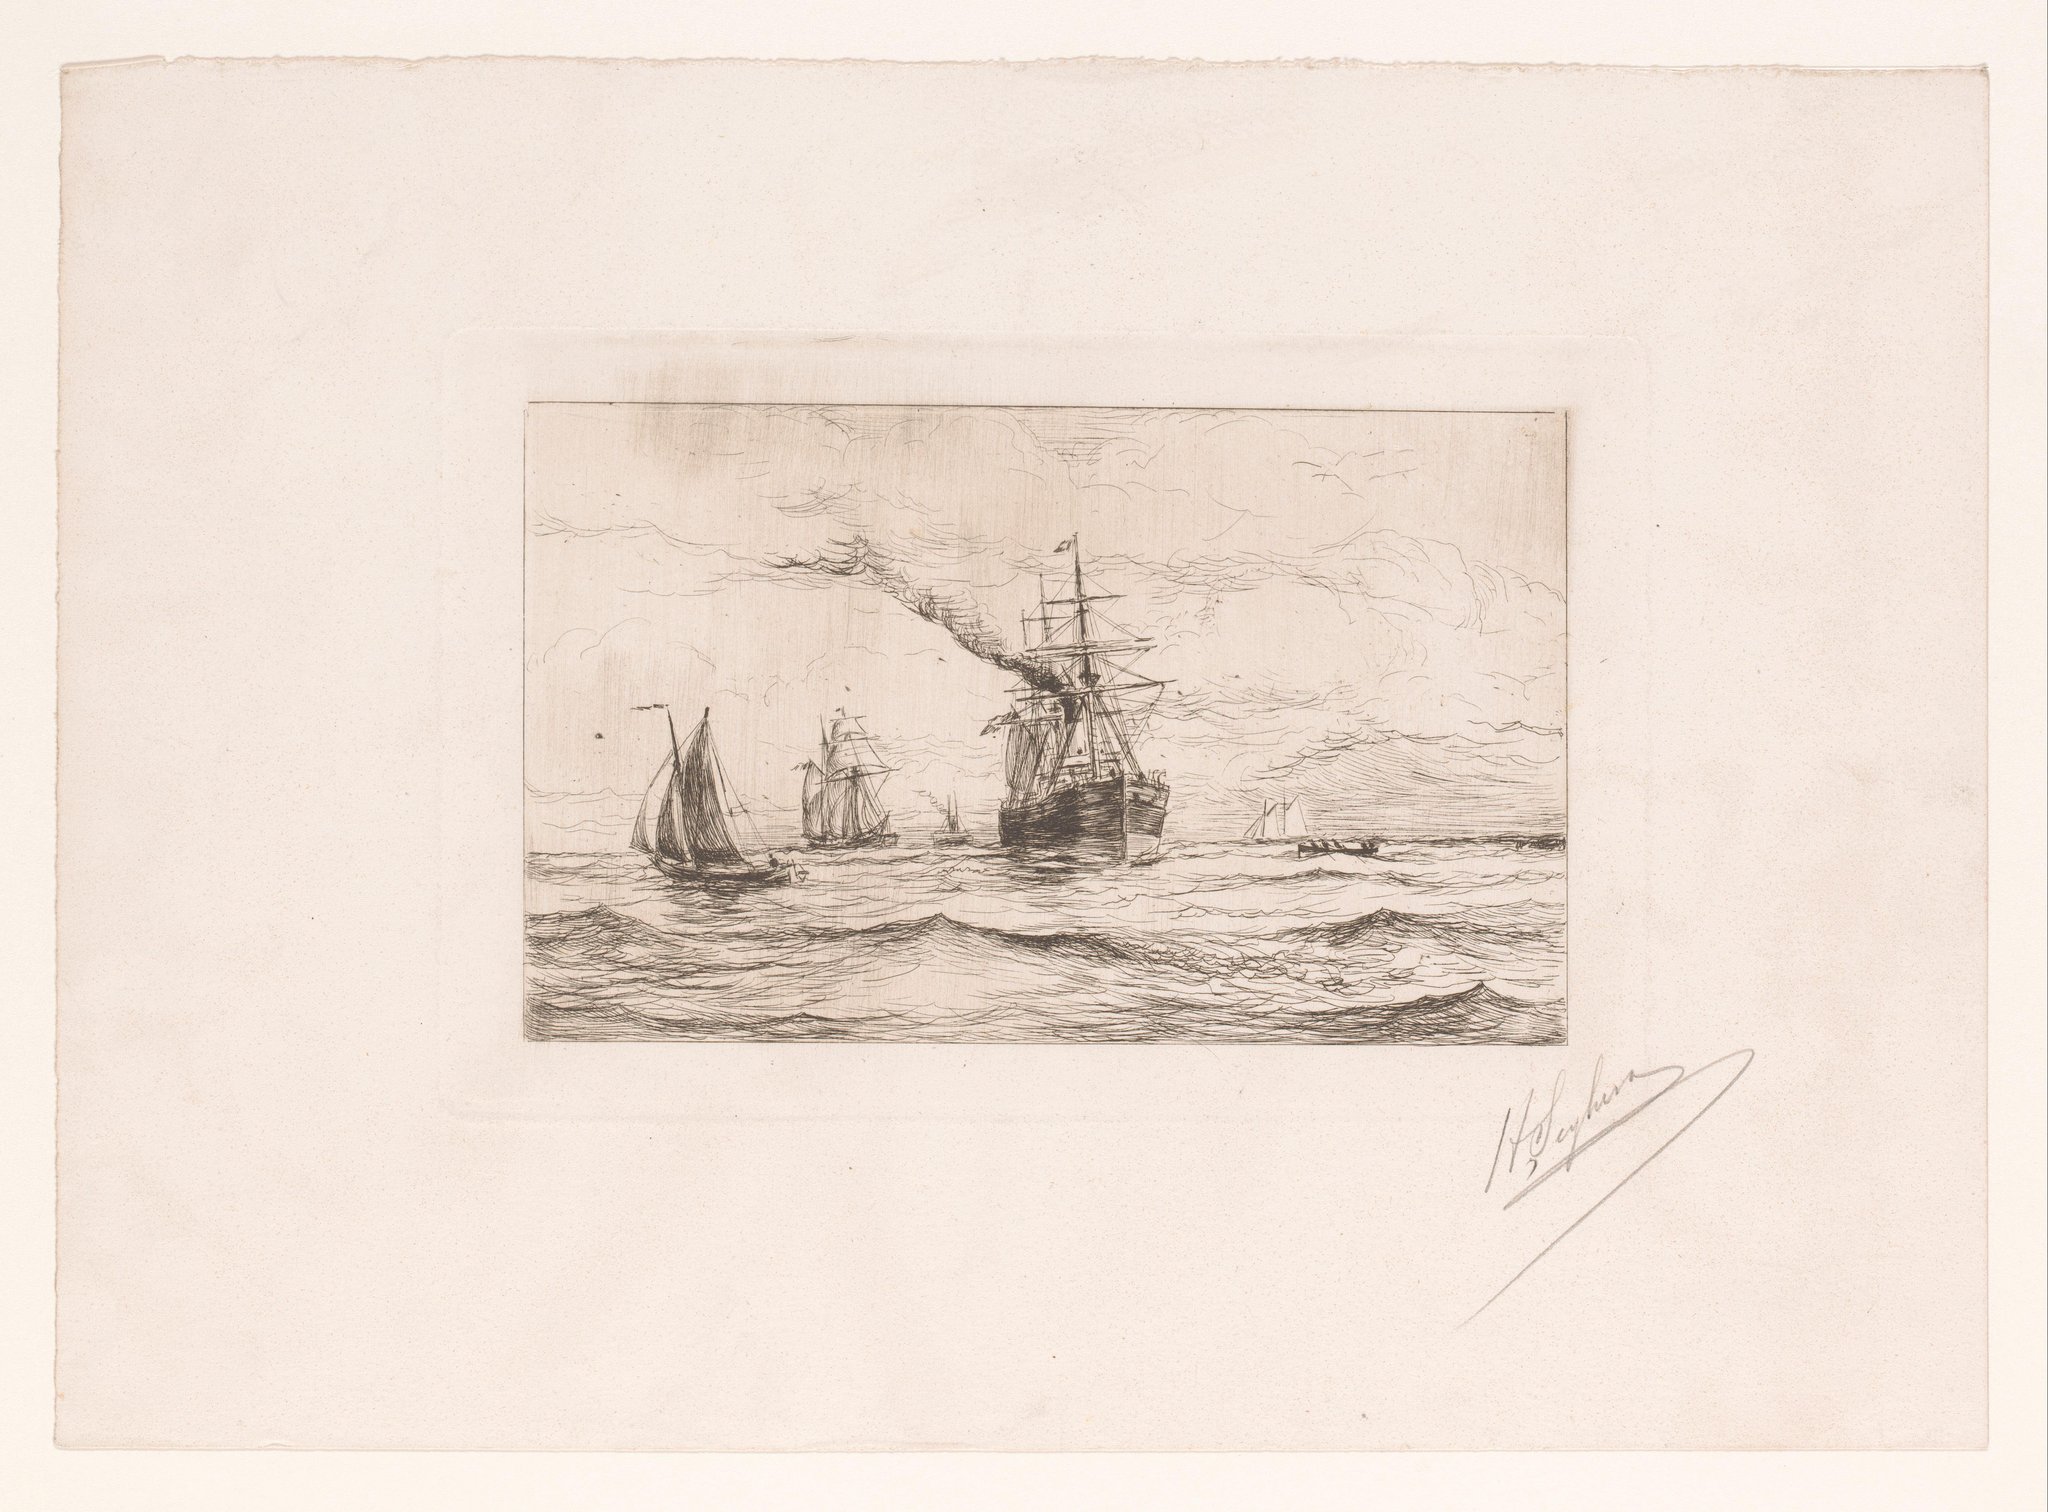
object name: print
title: Zeilschepen, een roeiboot, en een zeilstoomschip op open water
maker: henri seghers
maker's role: draughtsman, painter, print maker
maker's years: 1848-1919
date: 1880-1913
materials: paper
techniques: drypoint, etching, intaglio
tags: sailing-ship, sailing-boat, rowing-boat, canoe, etc., steamship, motorship, sea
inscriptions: collector's mark: Lugt 2228